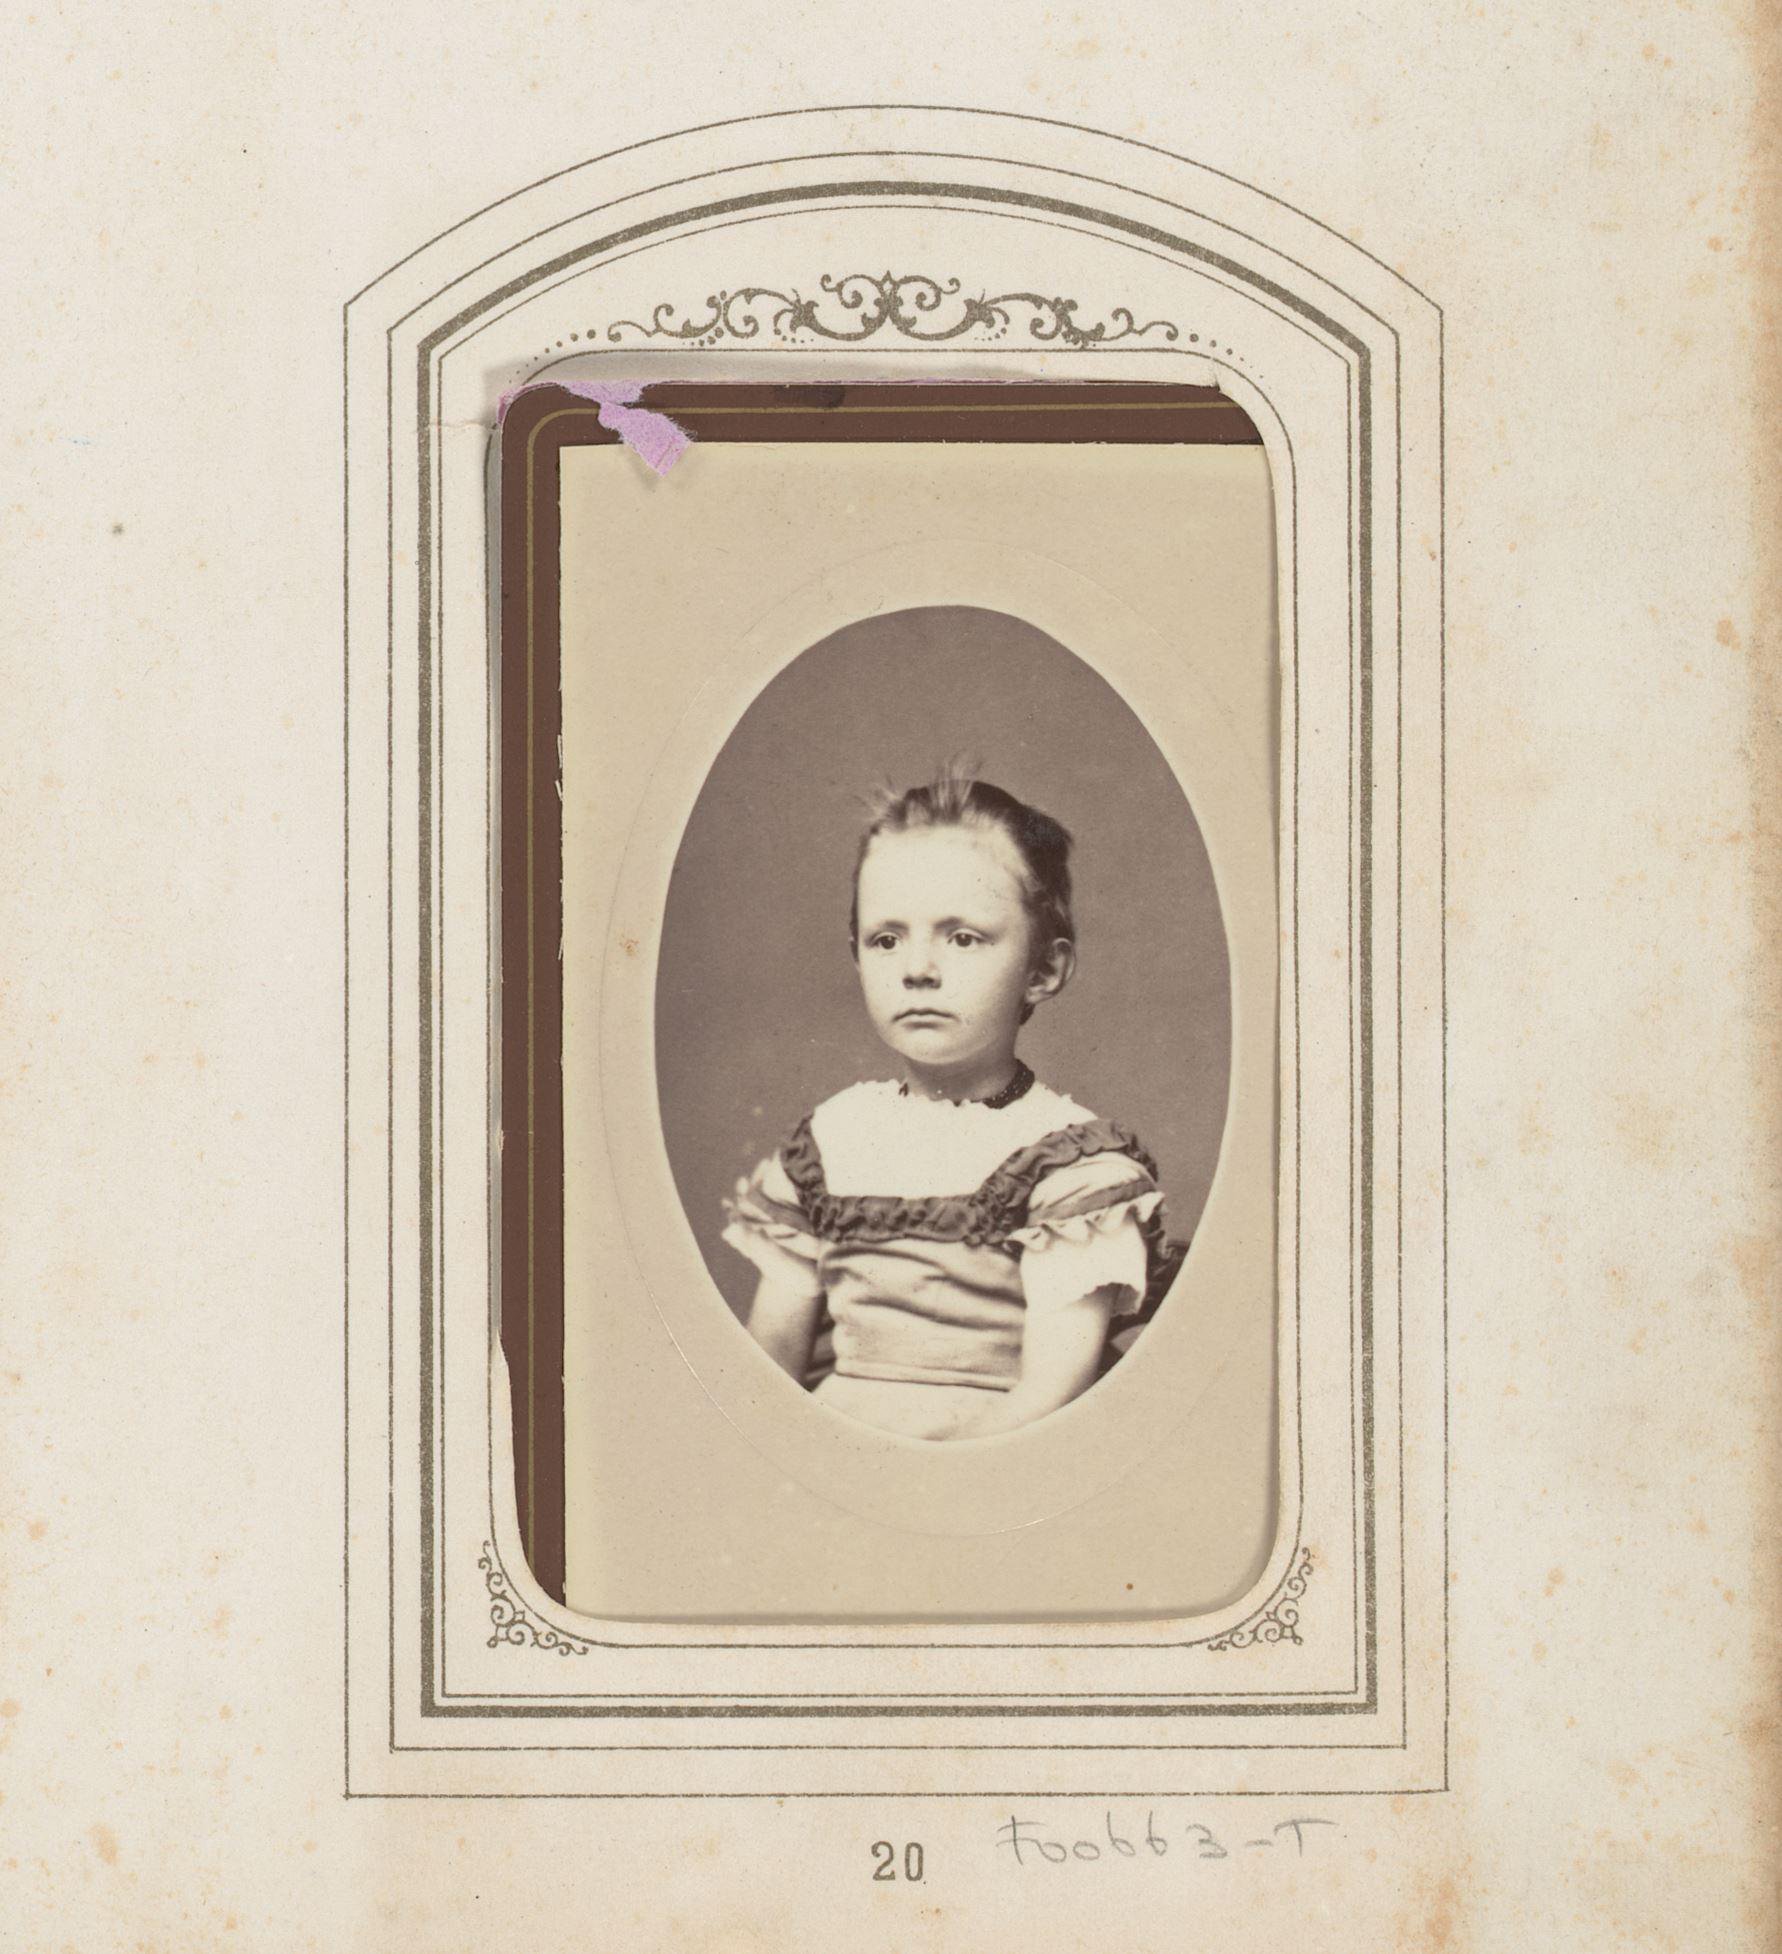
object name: semi enamel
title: Portret van een meisje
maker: charles binger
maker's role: print maker, printer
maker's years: 1830-1916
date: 1870-1890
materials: cardboard, celluloid, photographic support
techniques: albumen print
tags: historical persons - bb - woman, girl (child between toddler and youth)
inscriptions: number: ‘20’